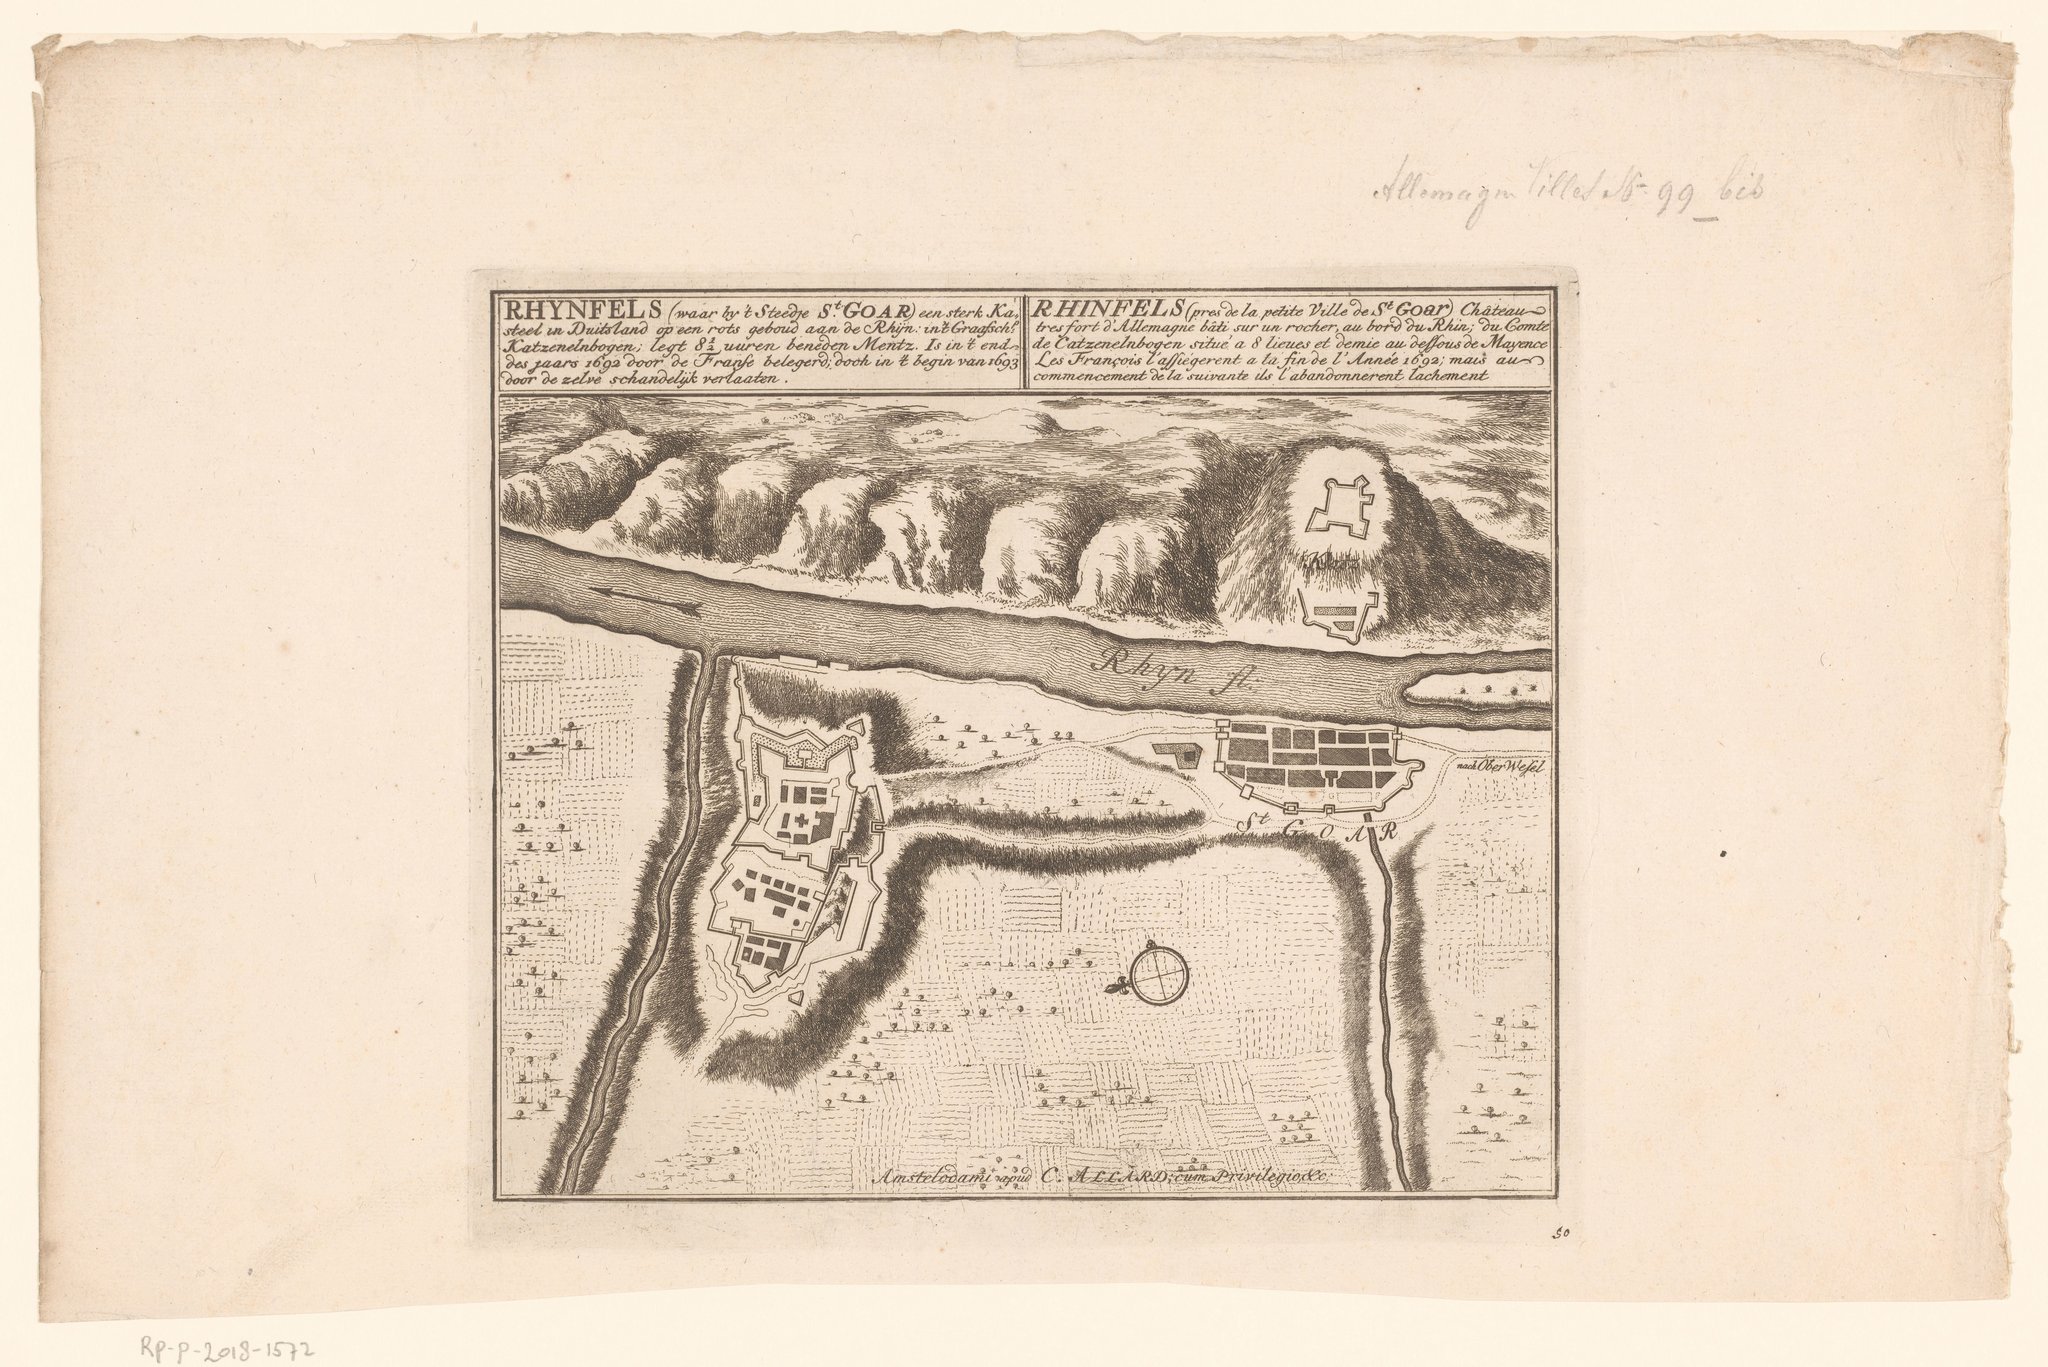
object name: area plan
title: Rhynfels (waar by 't steedje St. Goar) een sterk kasteel in Duitsland op een rots (...) / Rhinfels (pres de la petite ville de St. Goar) château tres fort d'allemagne (...)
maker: Anonymous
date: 1705-1728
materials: paper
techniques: etching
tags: castle, maps of cities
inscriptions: collector's mark: Lugt 2228